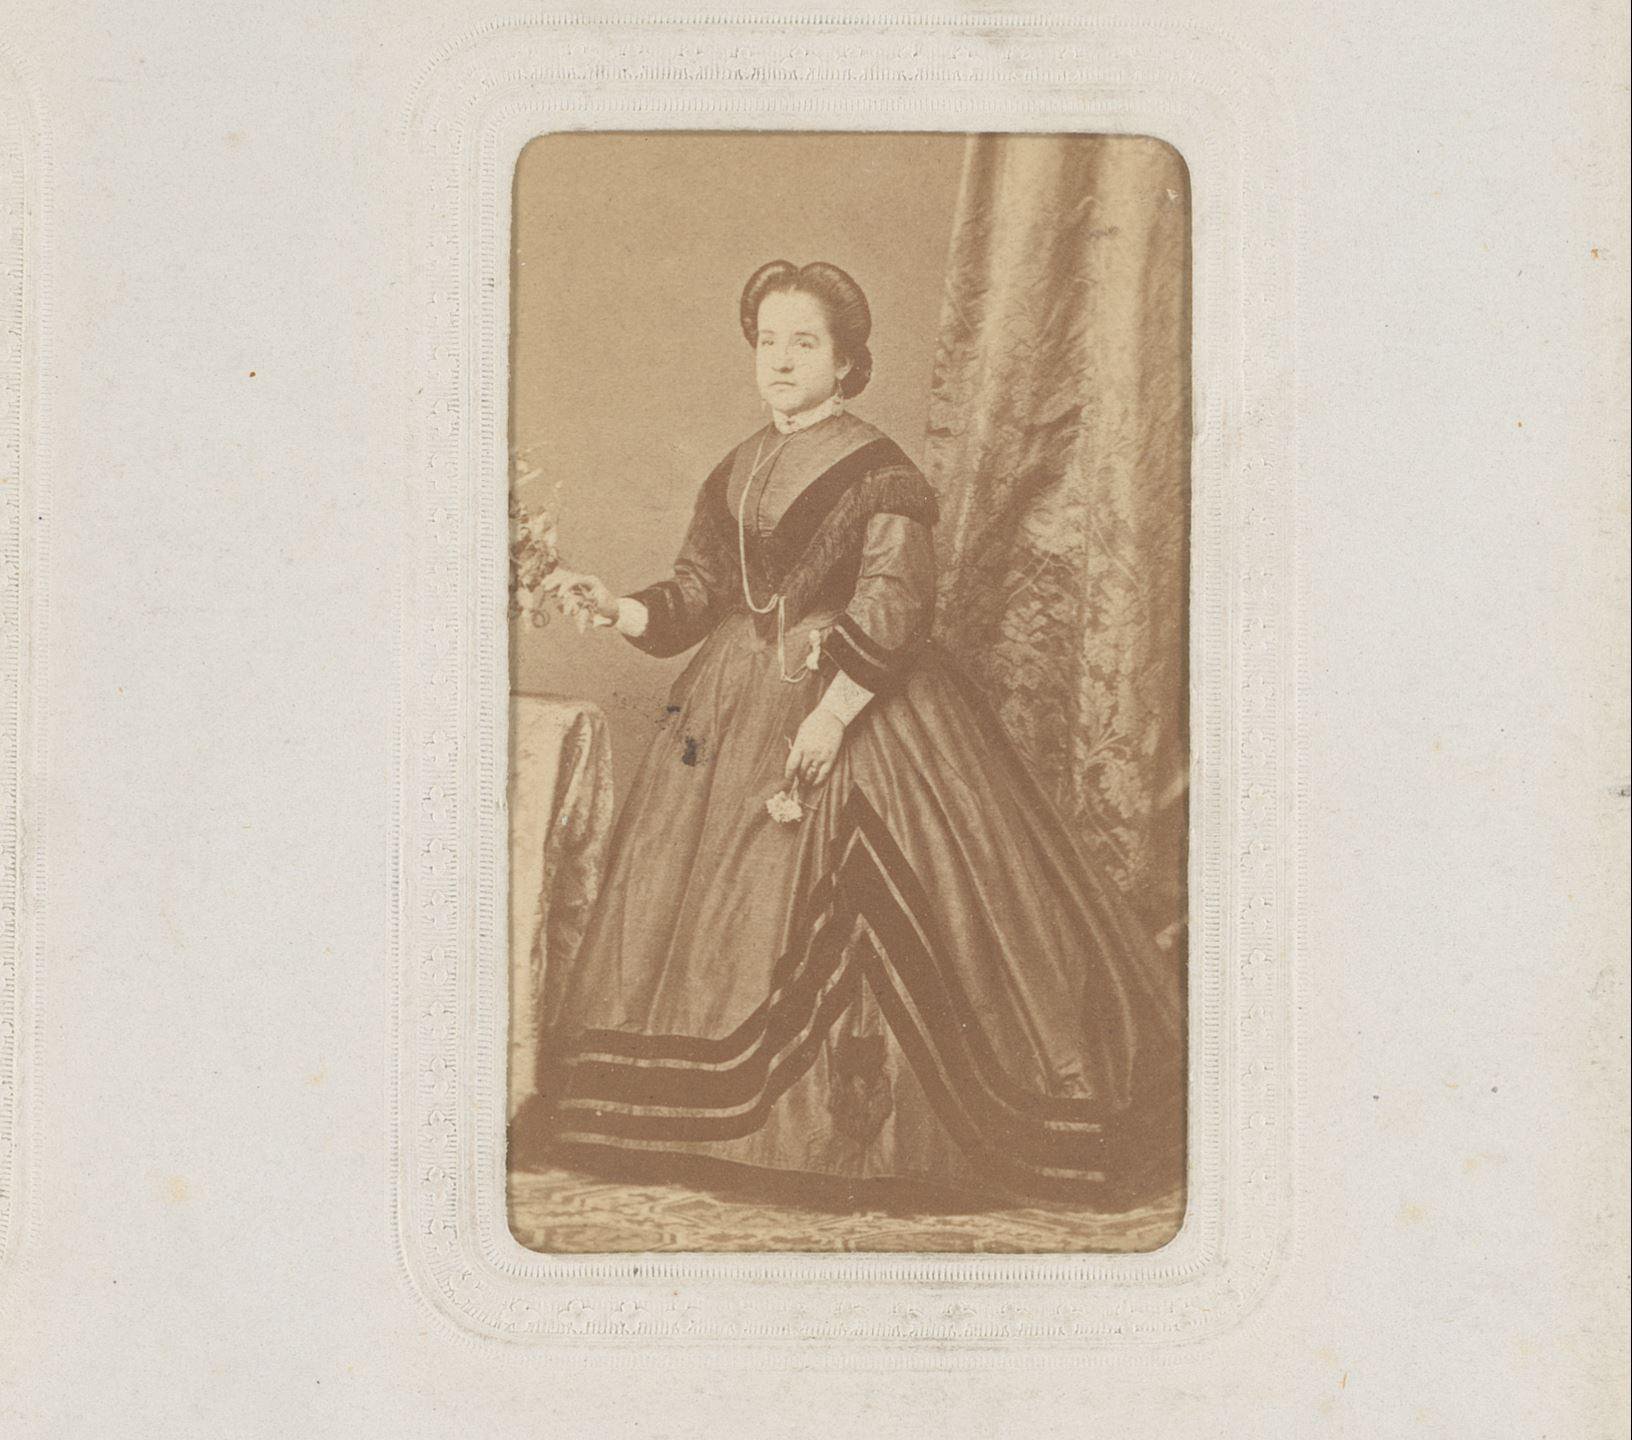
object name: carte de visite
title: Portret van een staande vrouw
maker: Anonymous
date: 1860-1890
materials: cardboard, photographic support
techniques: albumen print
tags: historical persons - bb - woman, standing figure - aa - female human figure